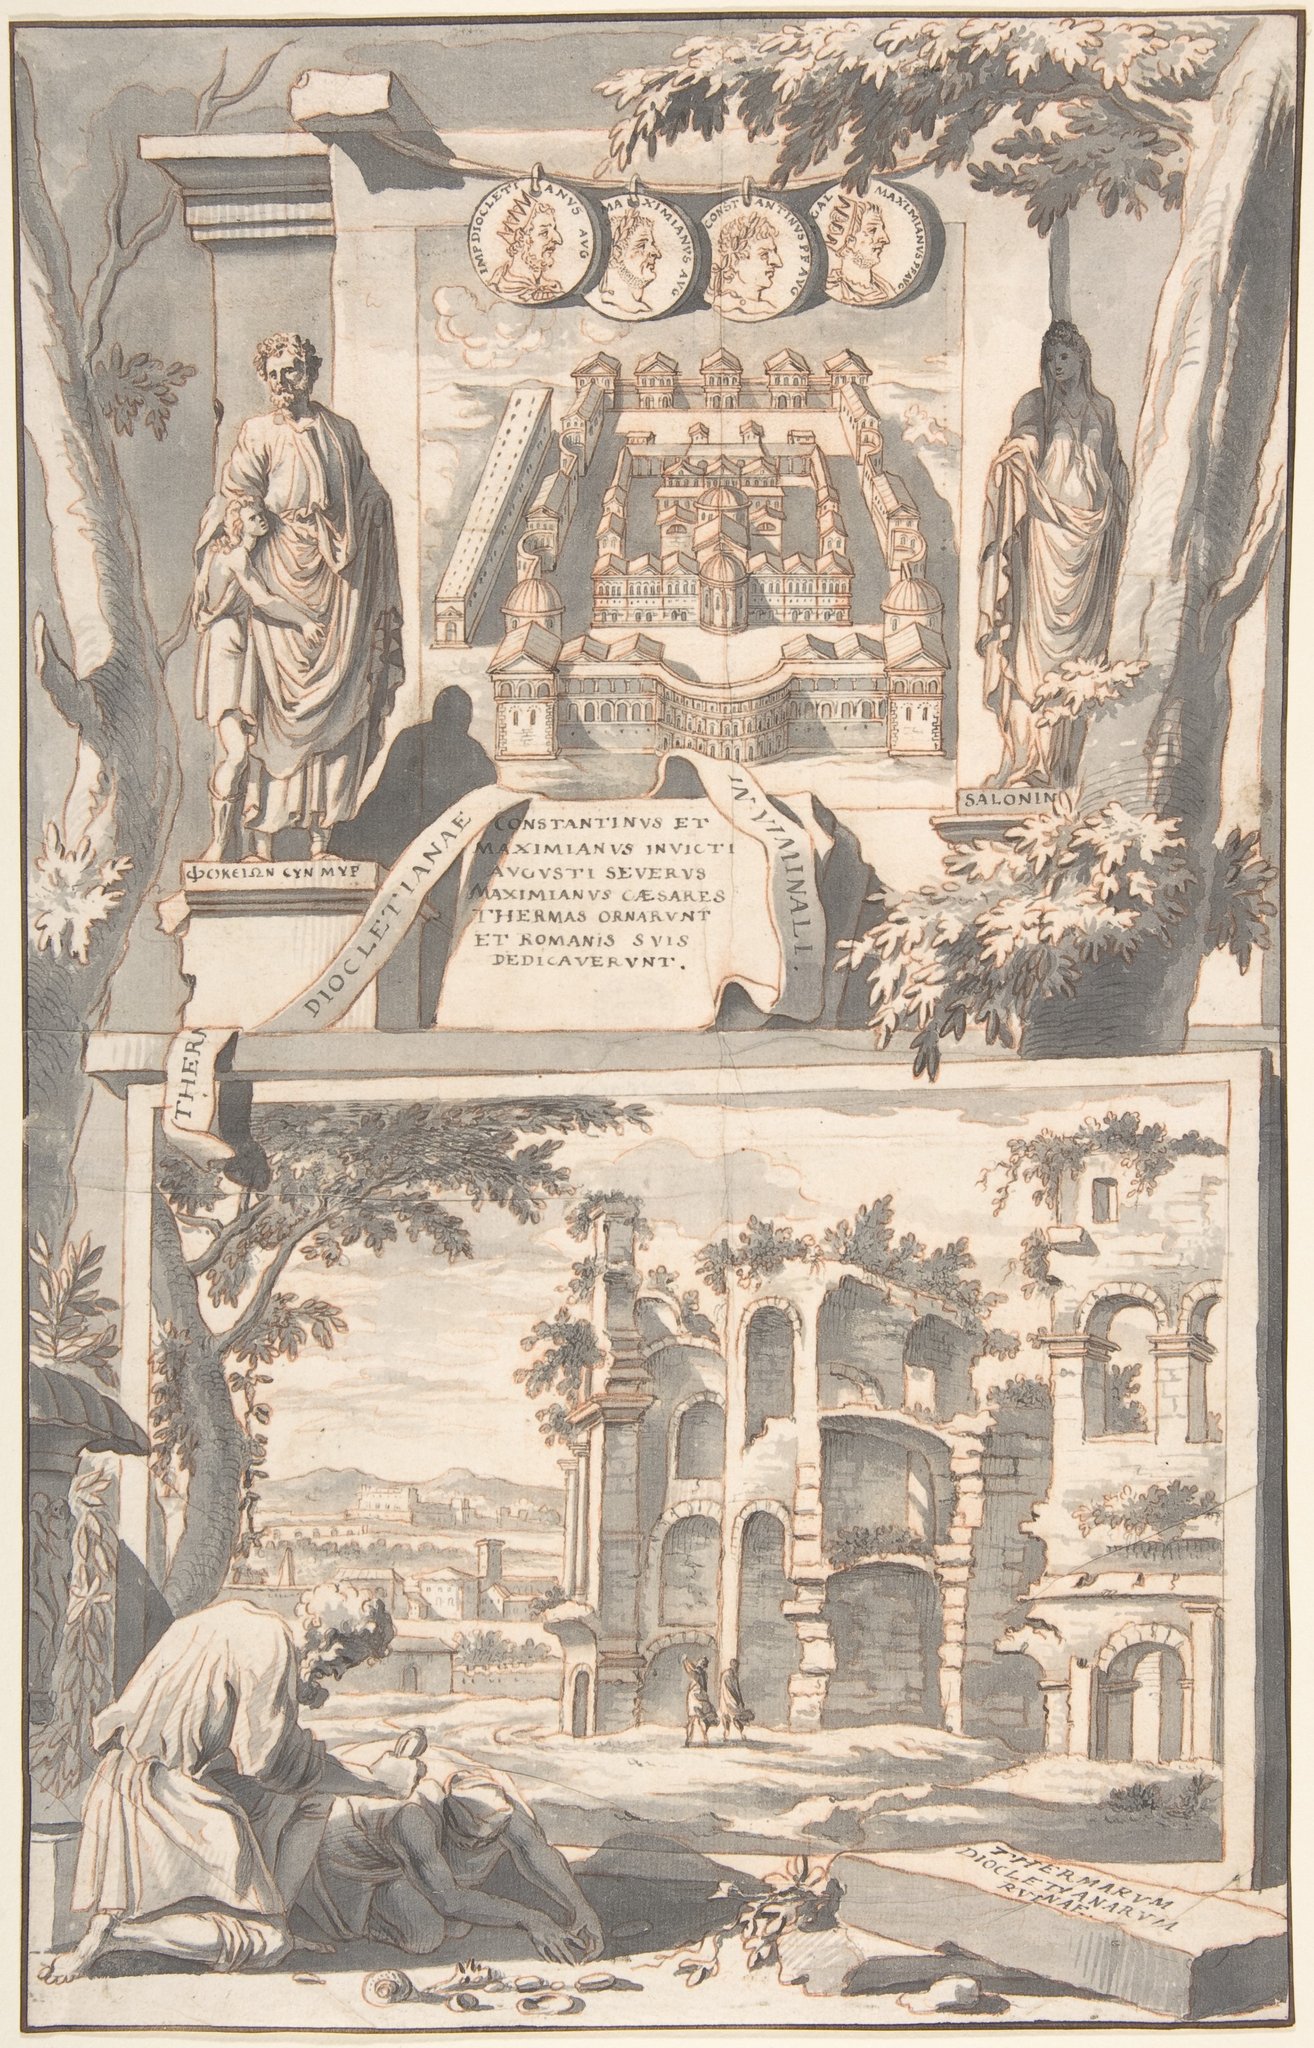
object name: drawing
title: A Reconstruction of the Thermae of Diocletian (above) and a View of the Ruins (below)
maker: jan goeree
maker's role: artist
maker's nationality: dutch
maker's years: 1670-1731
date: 1704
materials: chalk, ink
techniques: brush, pen, wash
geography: italy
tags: ruins,men,women,trees